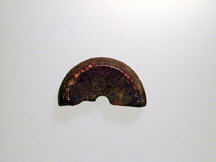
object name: whorl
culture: etruscan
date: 700-501 BCE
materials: amber